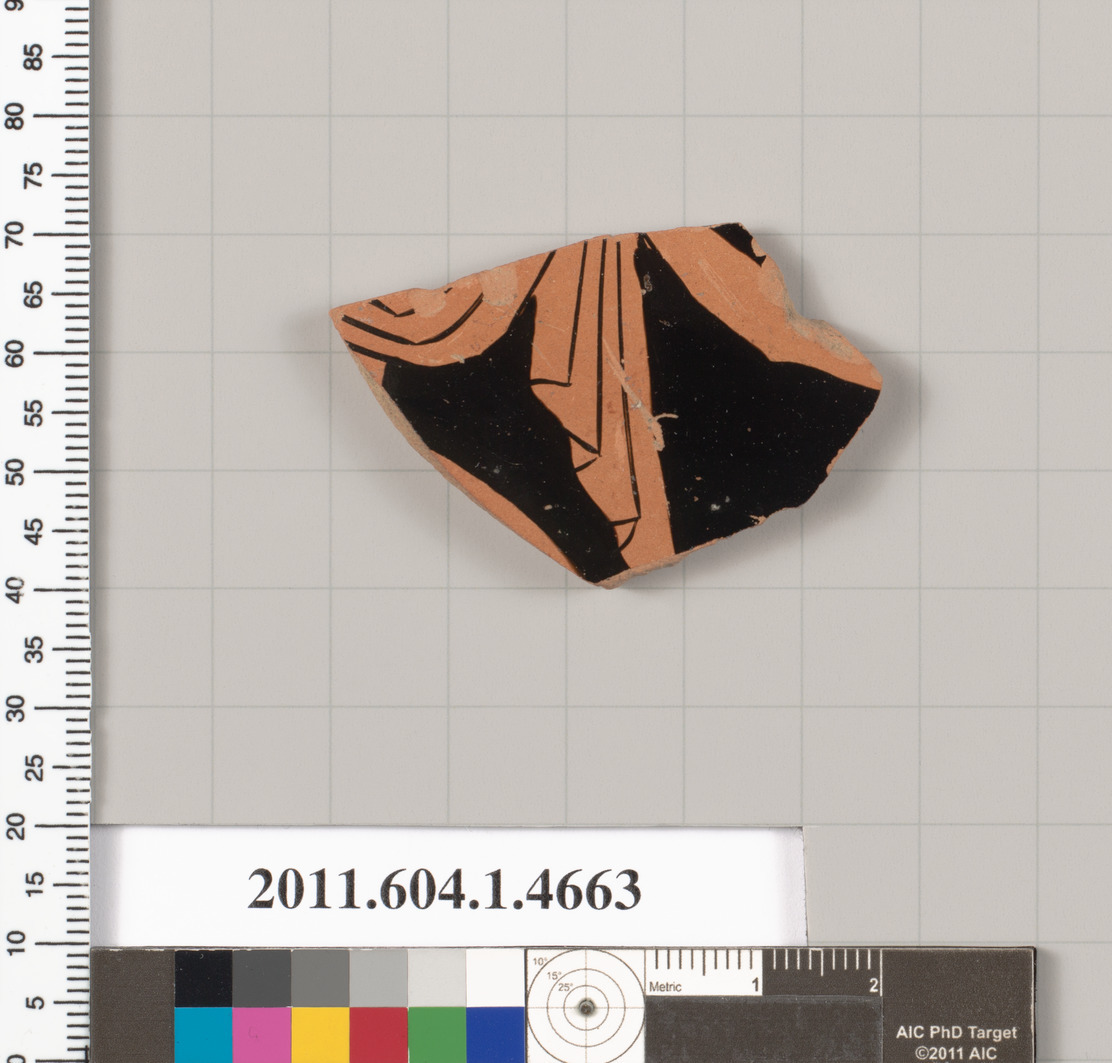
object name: kylix fragment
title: Terracotta fragment of a kylix (drinking cup)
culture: greek, attic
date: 500-480 BCE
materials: terracotta